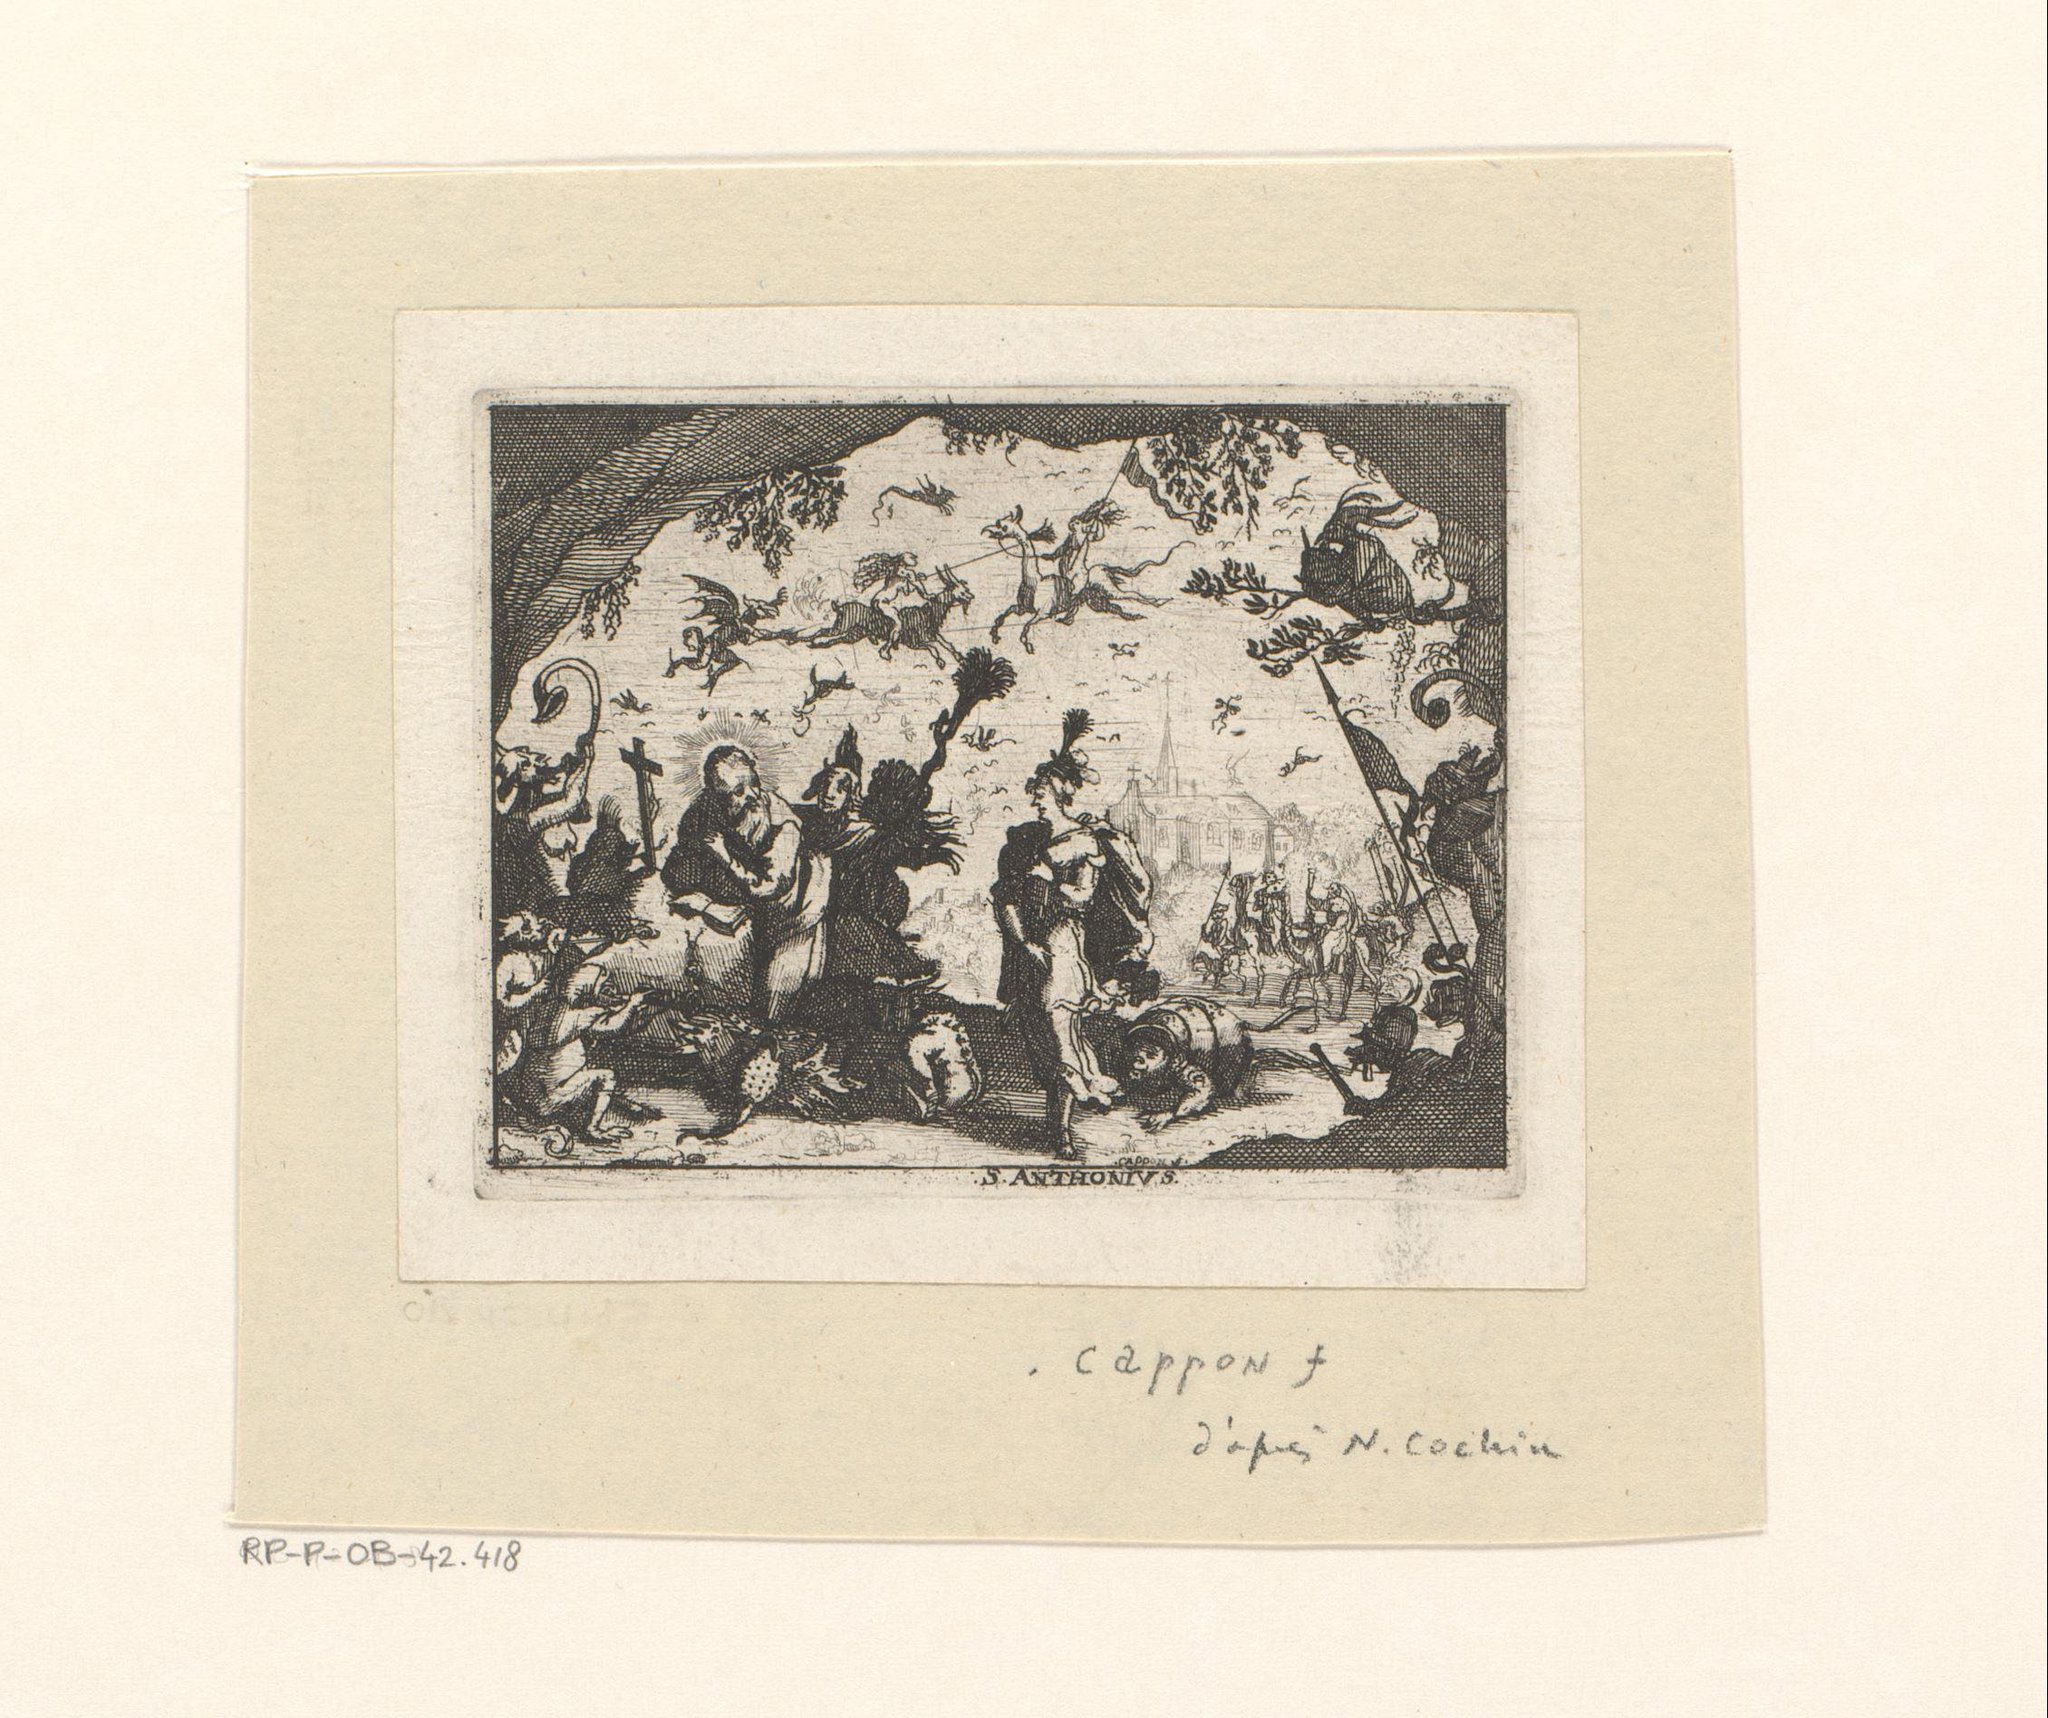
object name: print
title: Verzoeking van de heilige Antonius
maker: cappon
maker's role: print maker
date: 1600-1699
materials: paper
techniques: etching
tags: temptations of st. antony abbot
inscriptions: collector's mark: Lugt 240